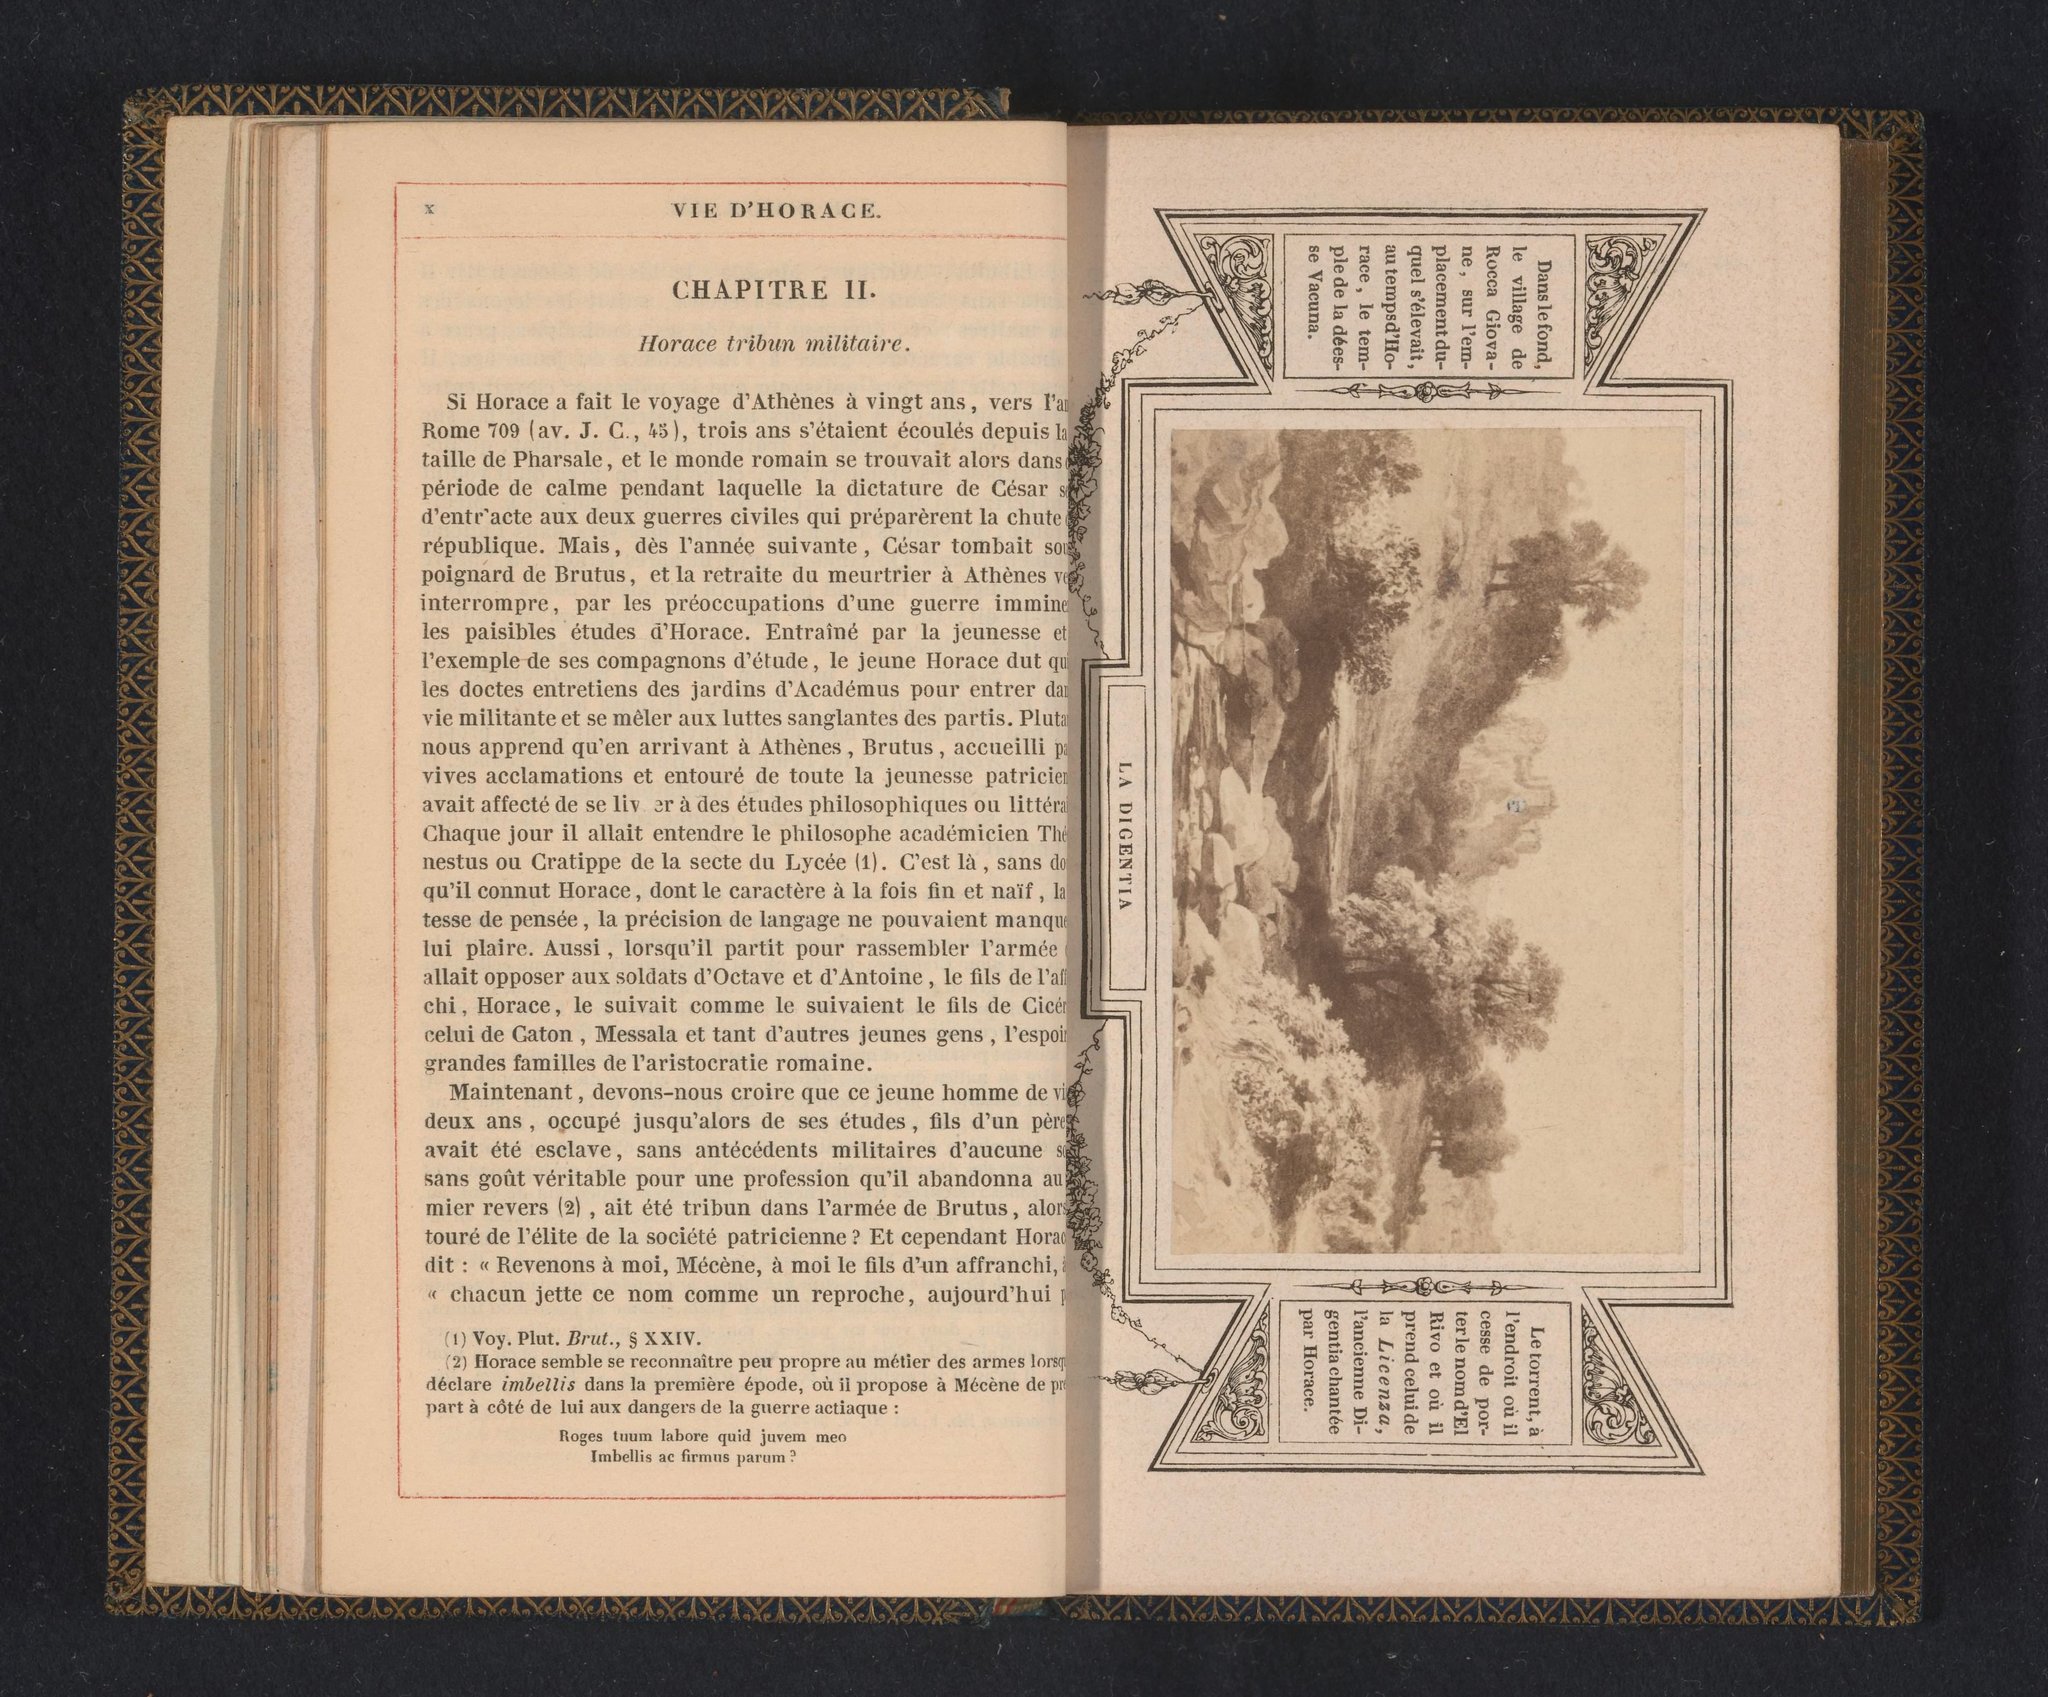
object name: photograph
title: La Digentia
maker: Anonymous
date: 1850-1855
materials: photographic support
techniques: albumen print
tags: city-view in general; 'veduta'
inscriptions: inscription: ‘Dans le fond (...) par Horace.’